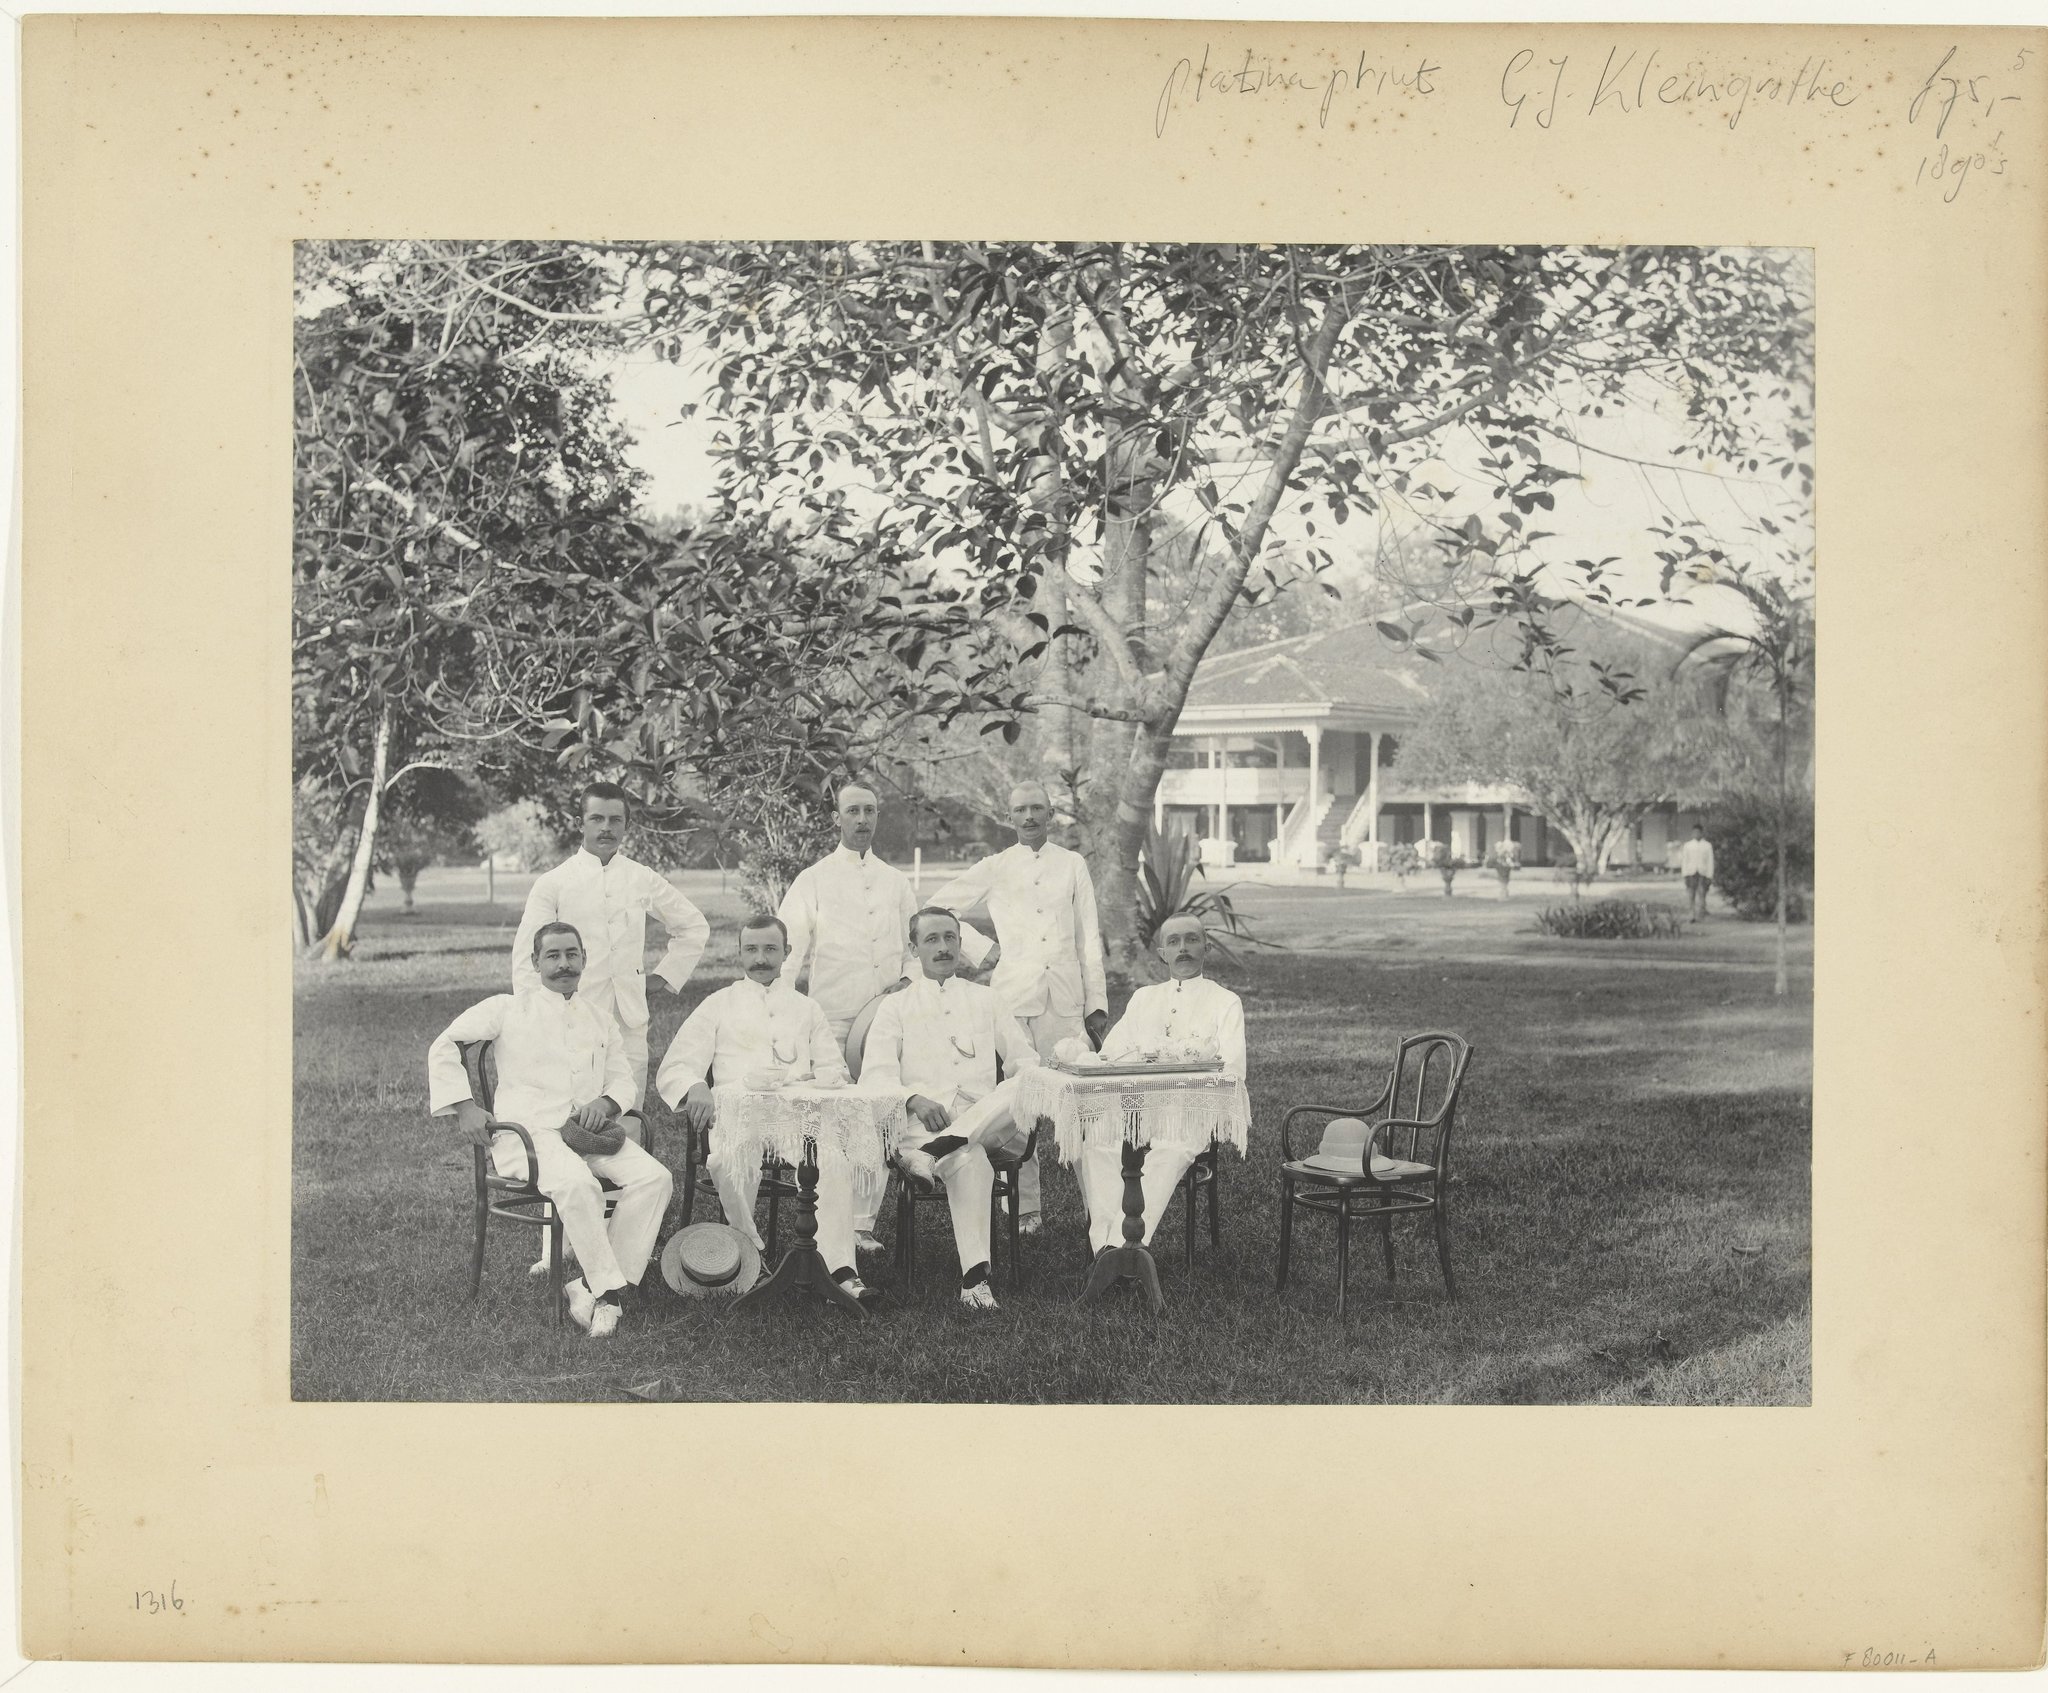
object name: photograph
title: Groep mannen, mogelijk voor Gouvernementspaleis in Batavia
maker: carl j. kleingrothe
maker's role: fotograaf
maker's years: 1864-1925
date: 1890-1900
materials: cardboard, photographic support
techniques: platinum process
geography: sumatra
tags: anonymous historical persons portrayed in a group, in a group-portrait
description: Groep mannen (Europeanen), mogelijk voor Gouvernementspaleis in Batavia, het huidige Jakarta. Foto geplakt op blad uit album, op verso bevindt zich nog een foto.